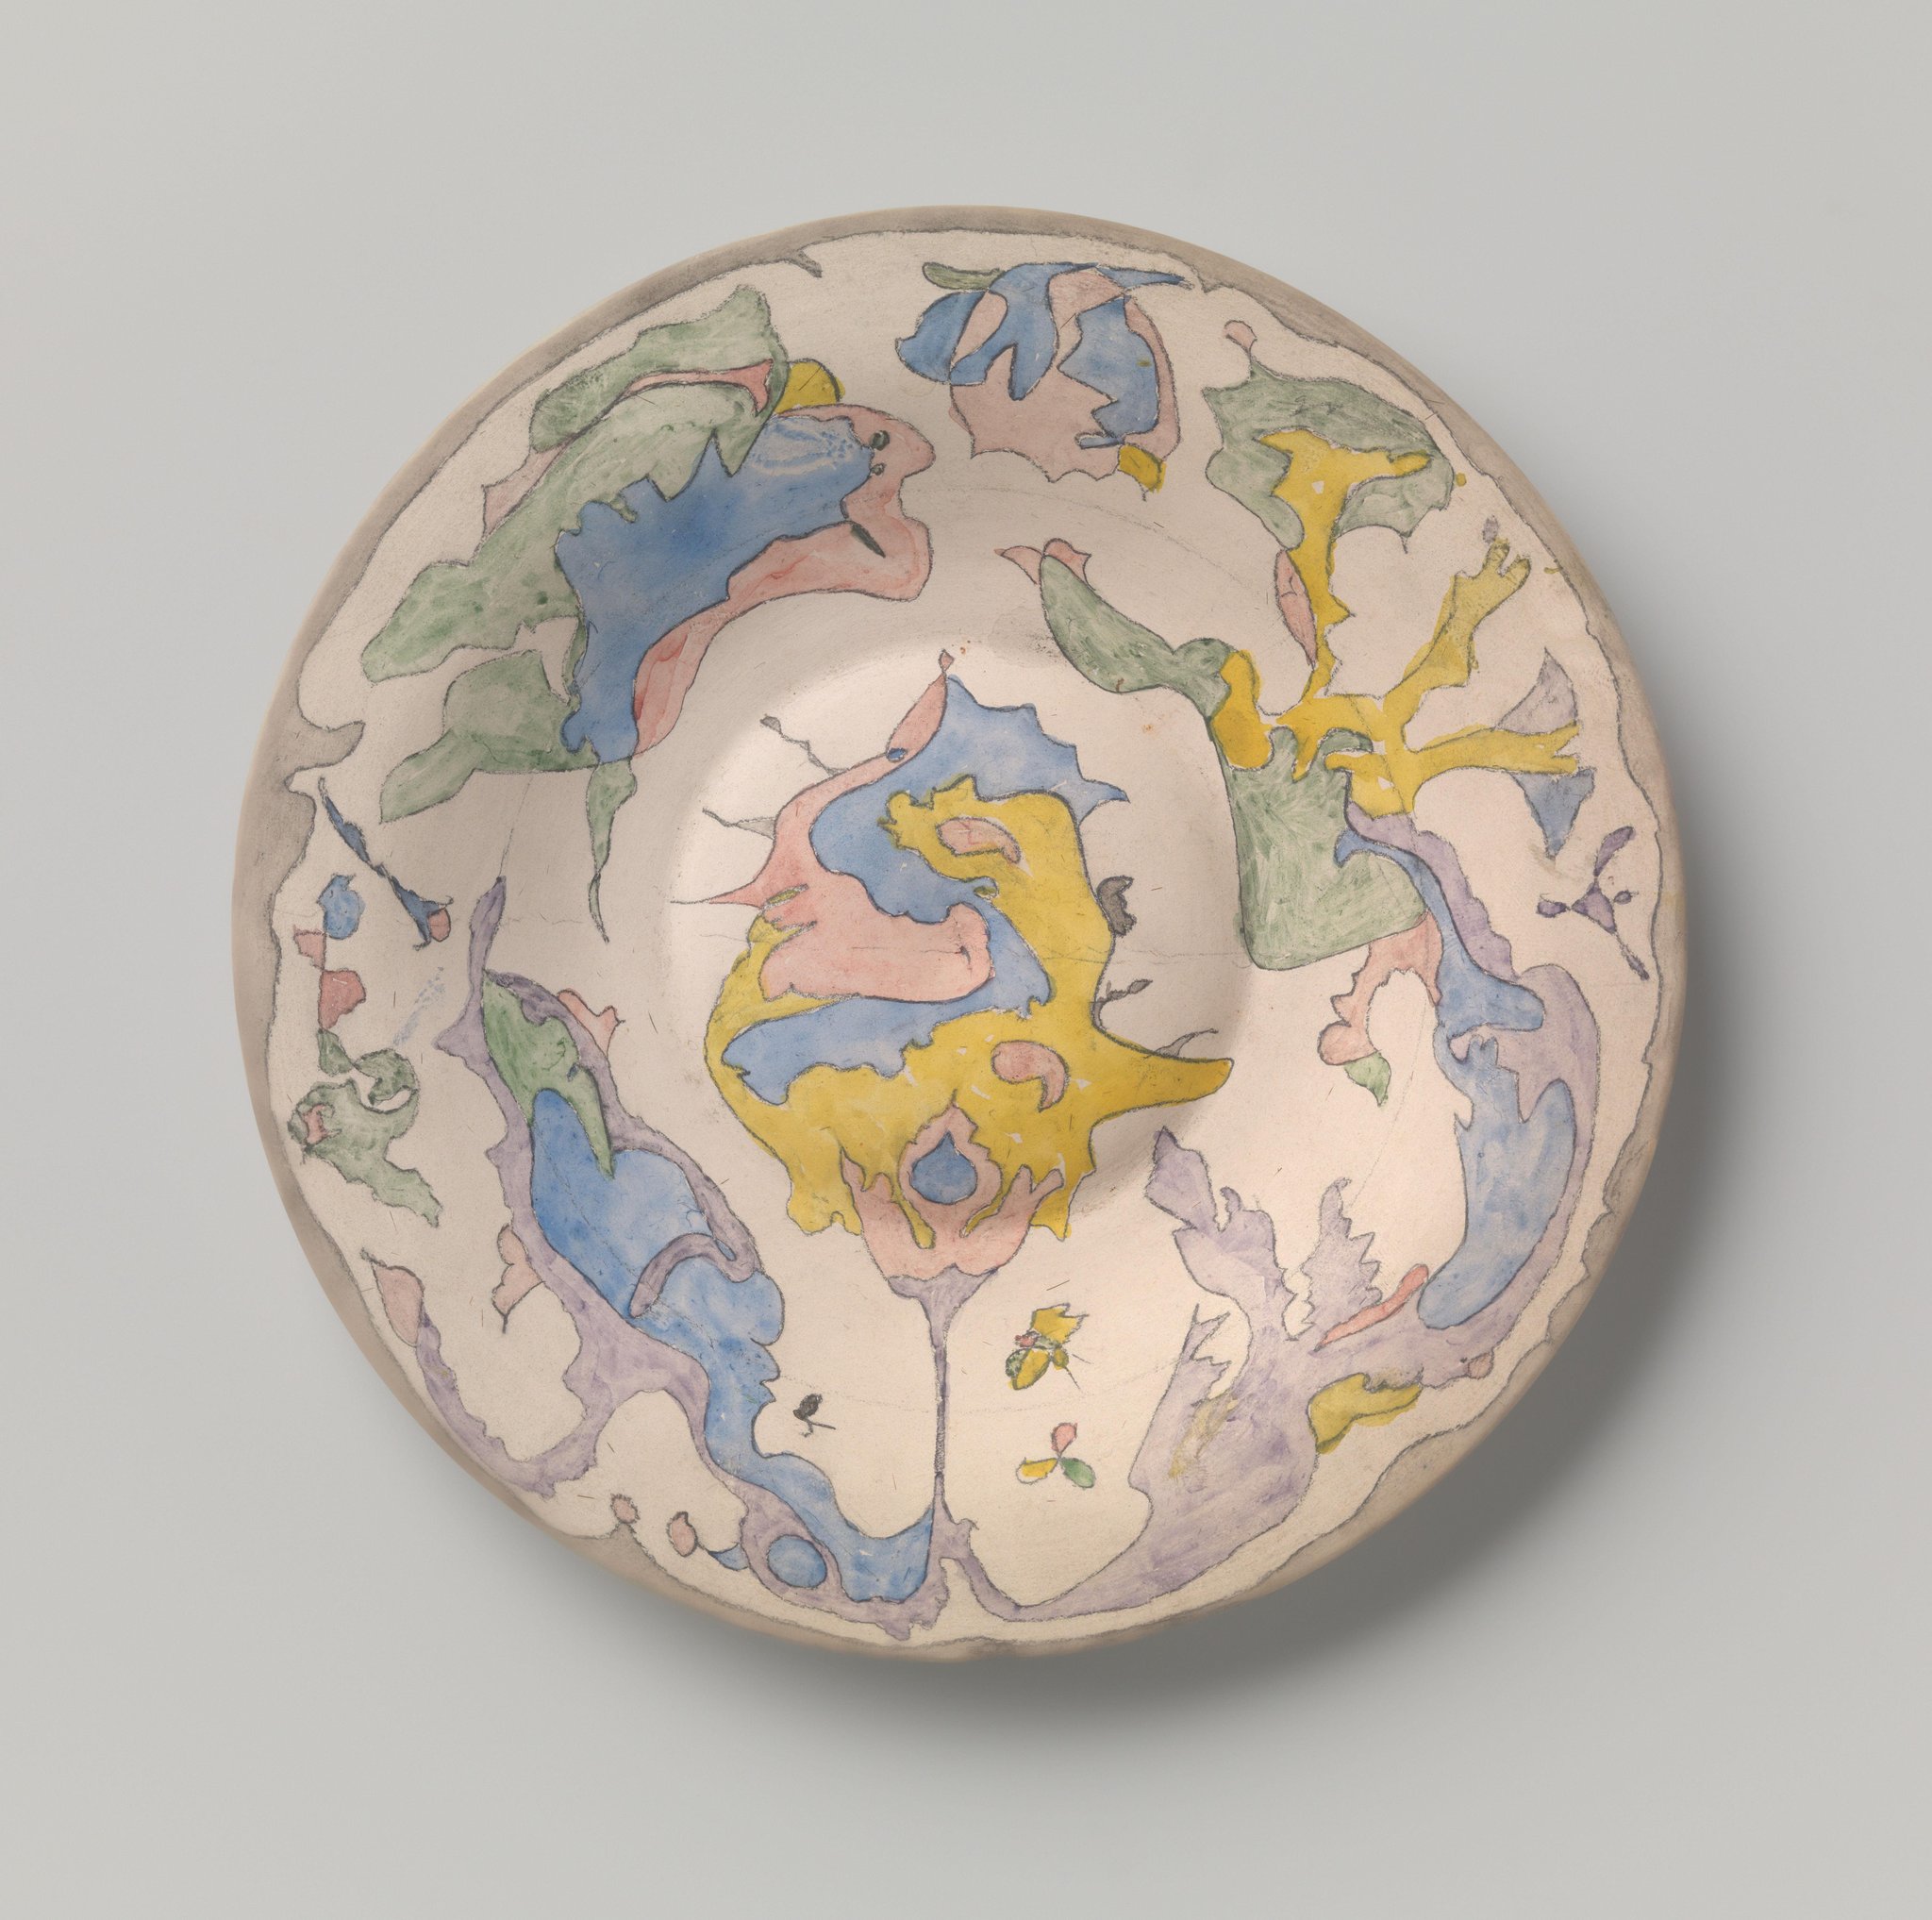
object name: platter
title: Schotel met verhoogde spiegel, polychroom beschilderd met waterverf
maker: theo colenbrander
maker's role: draughtsman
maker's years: 1841-1930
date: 1920-1922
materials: earthenware, watercolor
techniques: painted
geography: arnhem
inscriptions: inscription: ‘van alles’, inscription, mark: ‘44 (ingegrift)’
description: Schotel van aardewerk, met in het midden verhoogde spiegel, polychroom beschilderd met waterverf, ongeglazuurd.